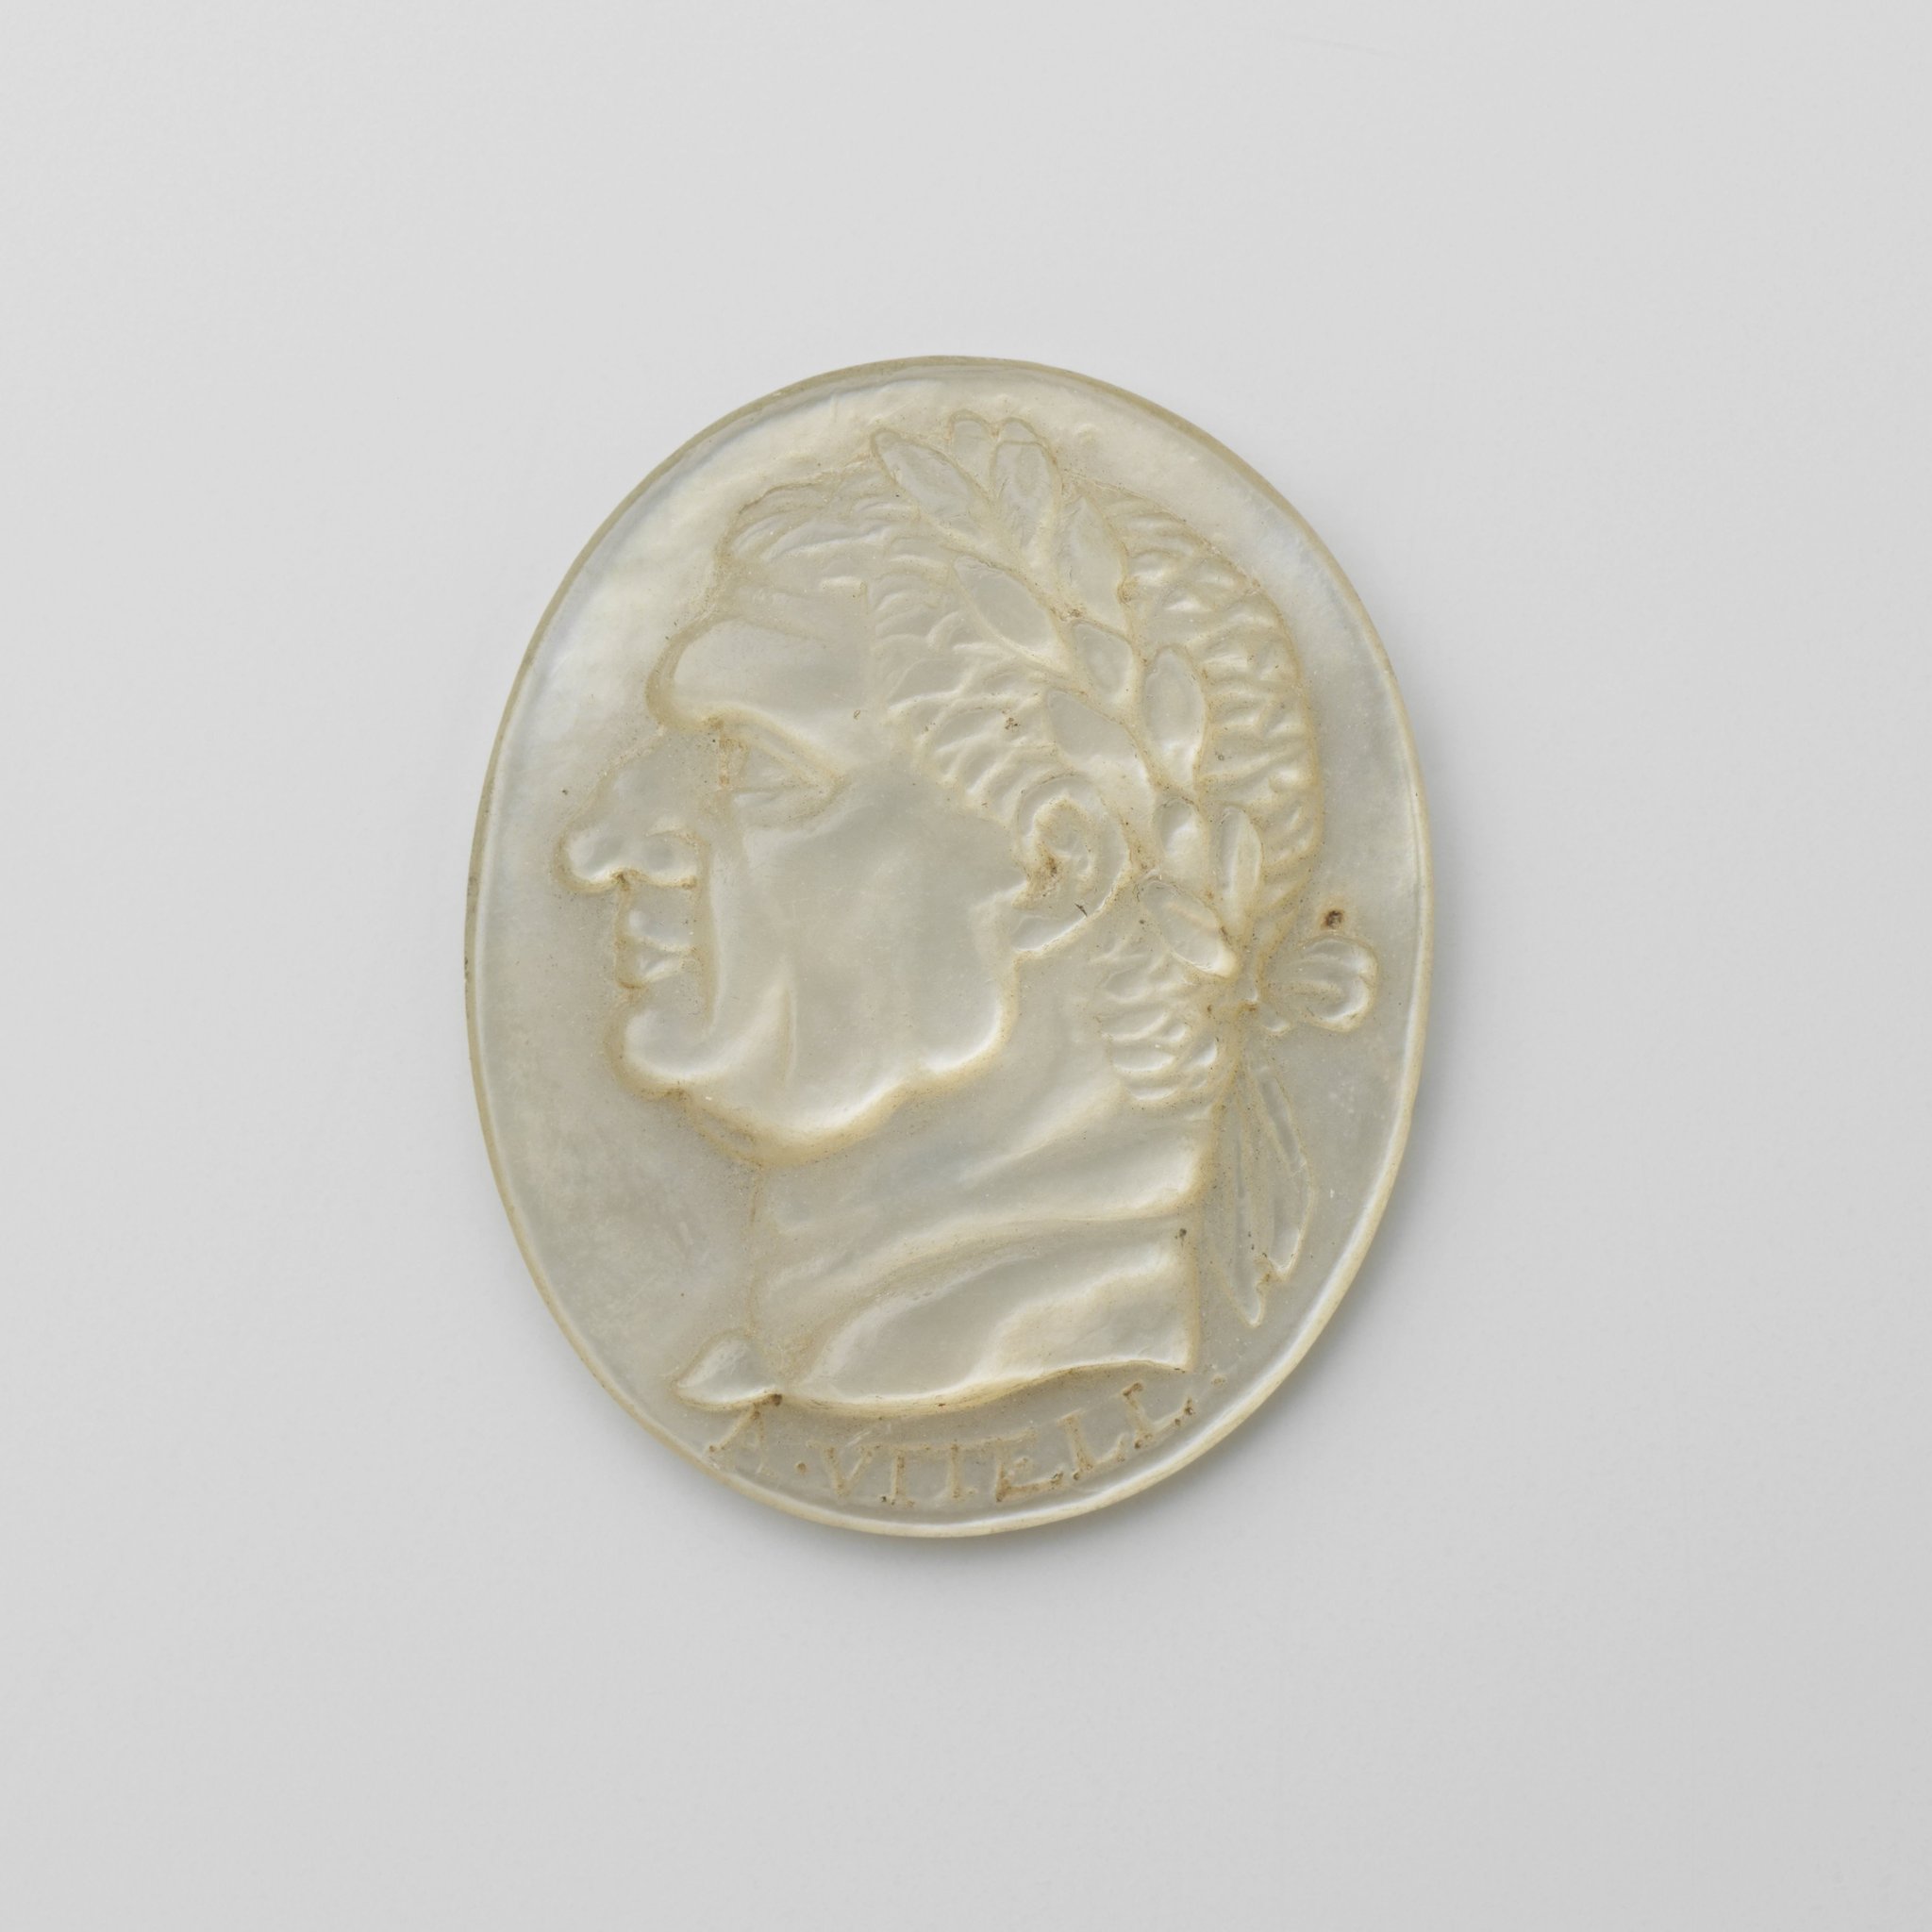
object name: locket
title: Aulus Vitellius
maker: Anonymous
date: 1700-1800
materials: mother of pearl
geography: netherlands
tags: consul, vitellius (keizer van het romeinse rijk)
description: Een medaillon van parelmoer, waarop een afbeelding is gesneden van een Romeinse keizer, met randschrift: A.VITELL.